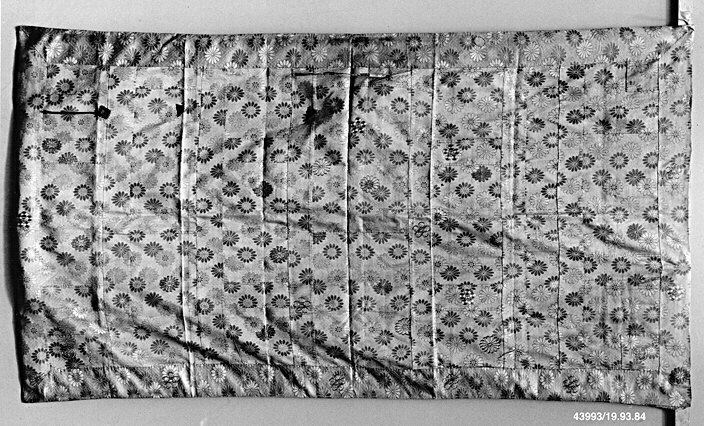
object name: robe, priest's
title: Priest's Robe (Shichijō)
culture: japanese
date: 1615-1868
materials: metal thread, silk